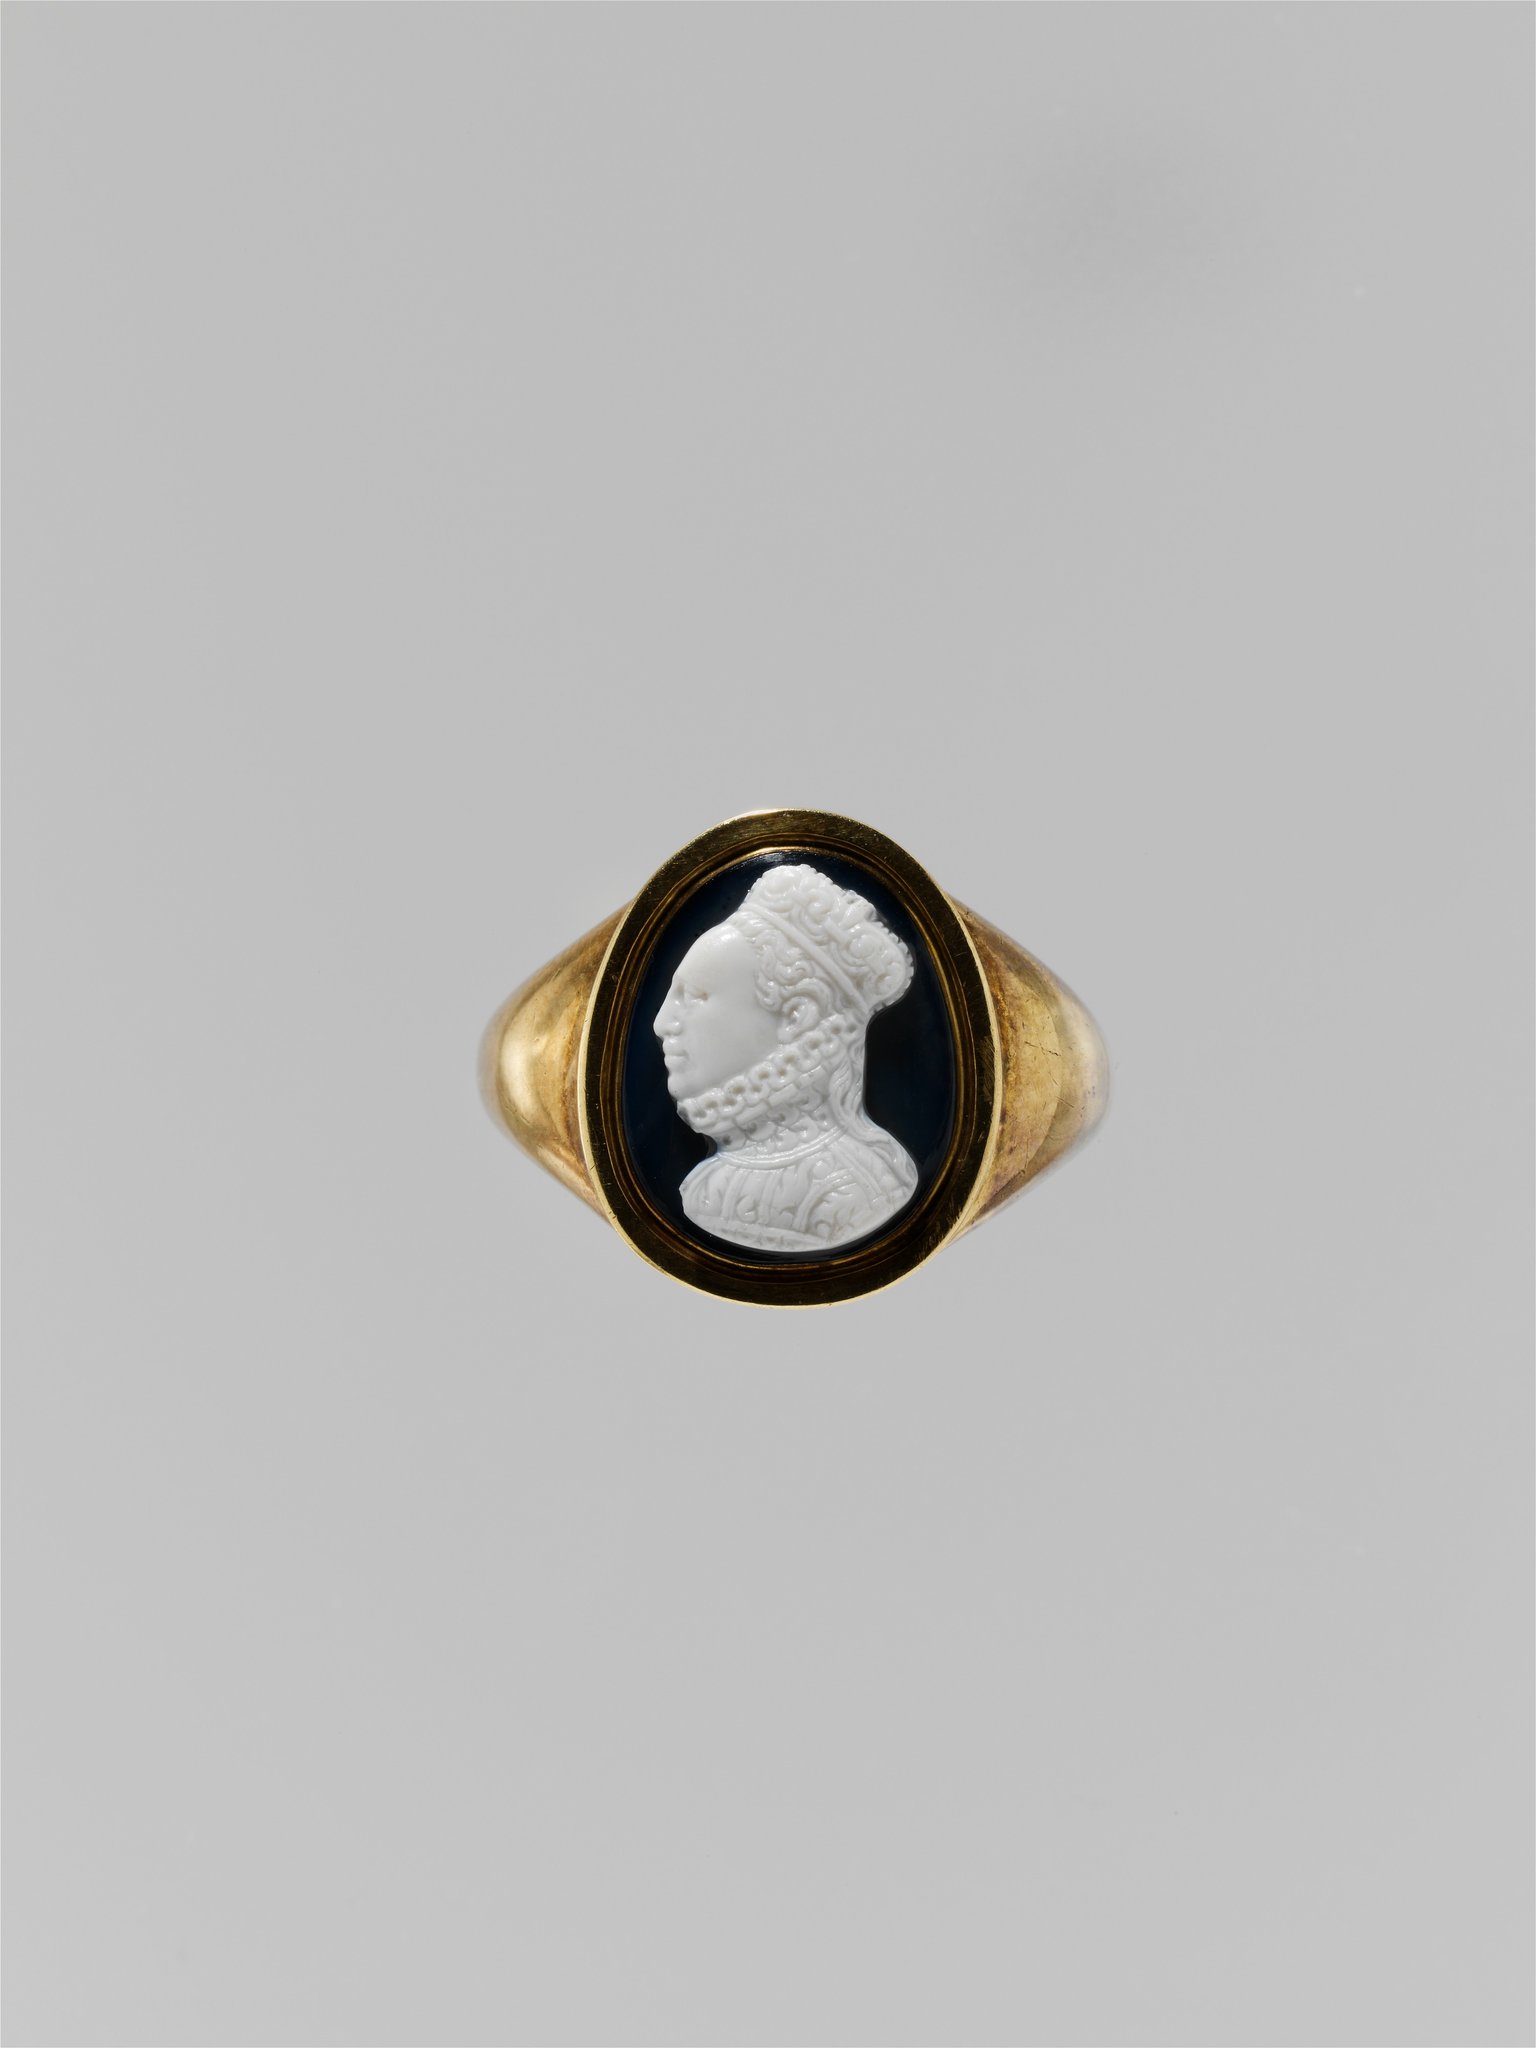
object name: cameo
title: Elizabeth I of England (1533–1603)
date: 1570-1600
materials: gold, onyx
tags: elizabeth i,profiles